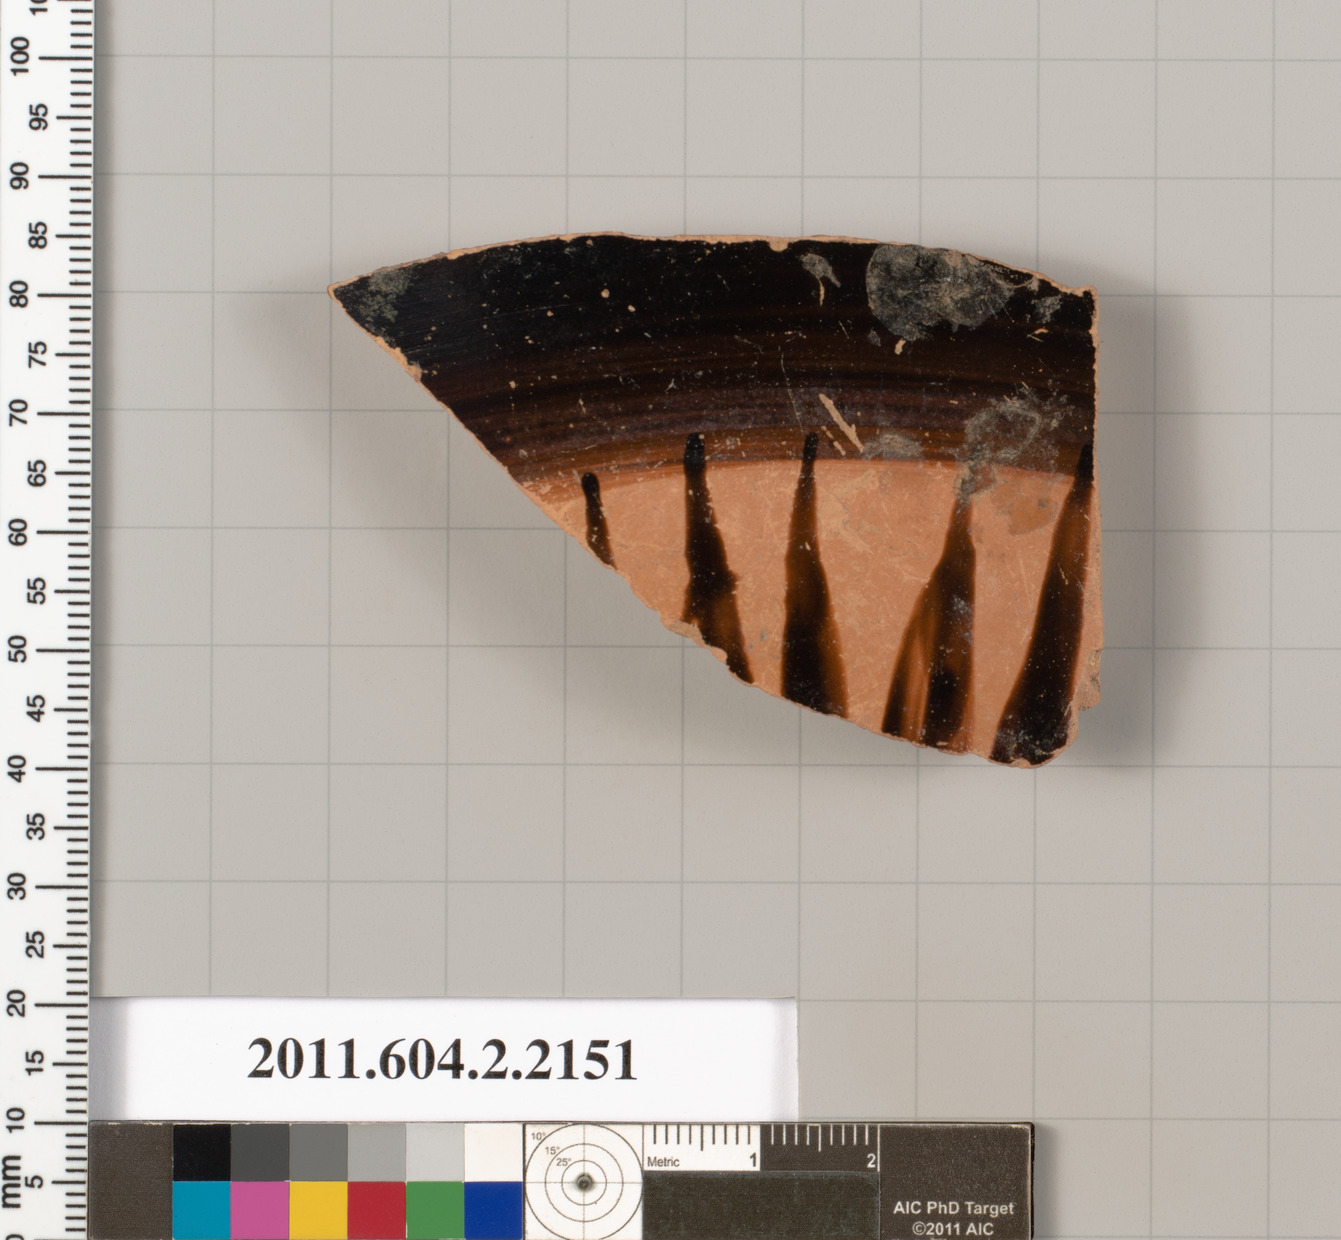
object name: amphora fragment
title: Terracotta fragments of an amphora (jar)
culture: greek, attic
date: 475-451 BCE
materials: terracotta